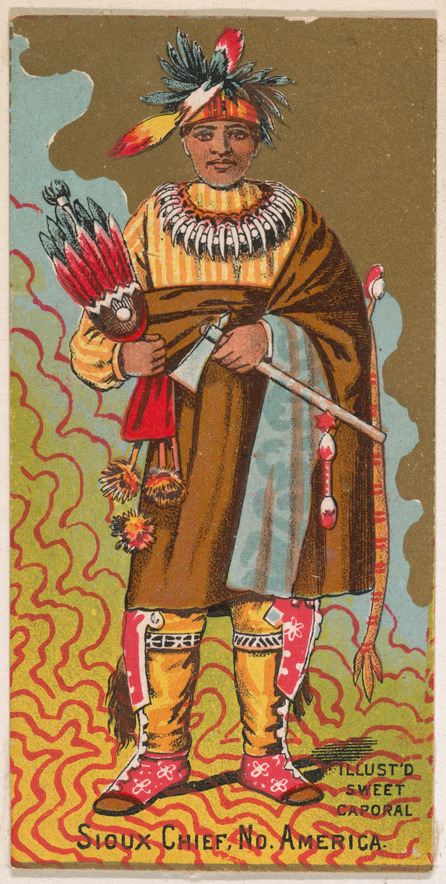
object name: print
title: Sioux Chief, North America, from the Military Series (N224) issued by Kinney Tobacco Company to promote Sweet Caporal Cigarettes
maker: kinney brothers tobacco company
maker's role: publisher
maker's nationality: american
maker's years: 1869-2011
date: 1888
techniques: color lithograph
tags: men,axes